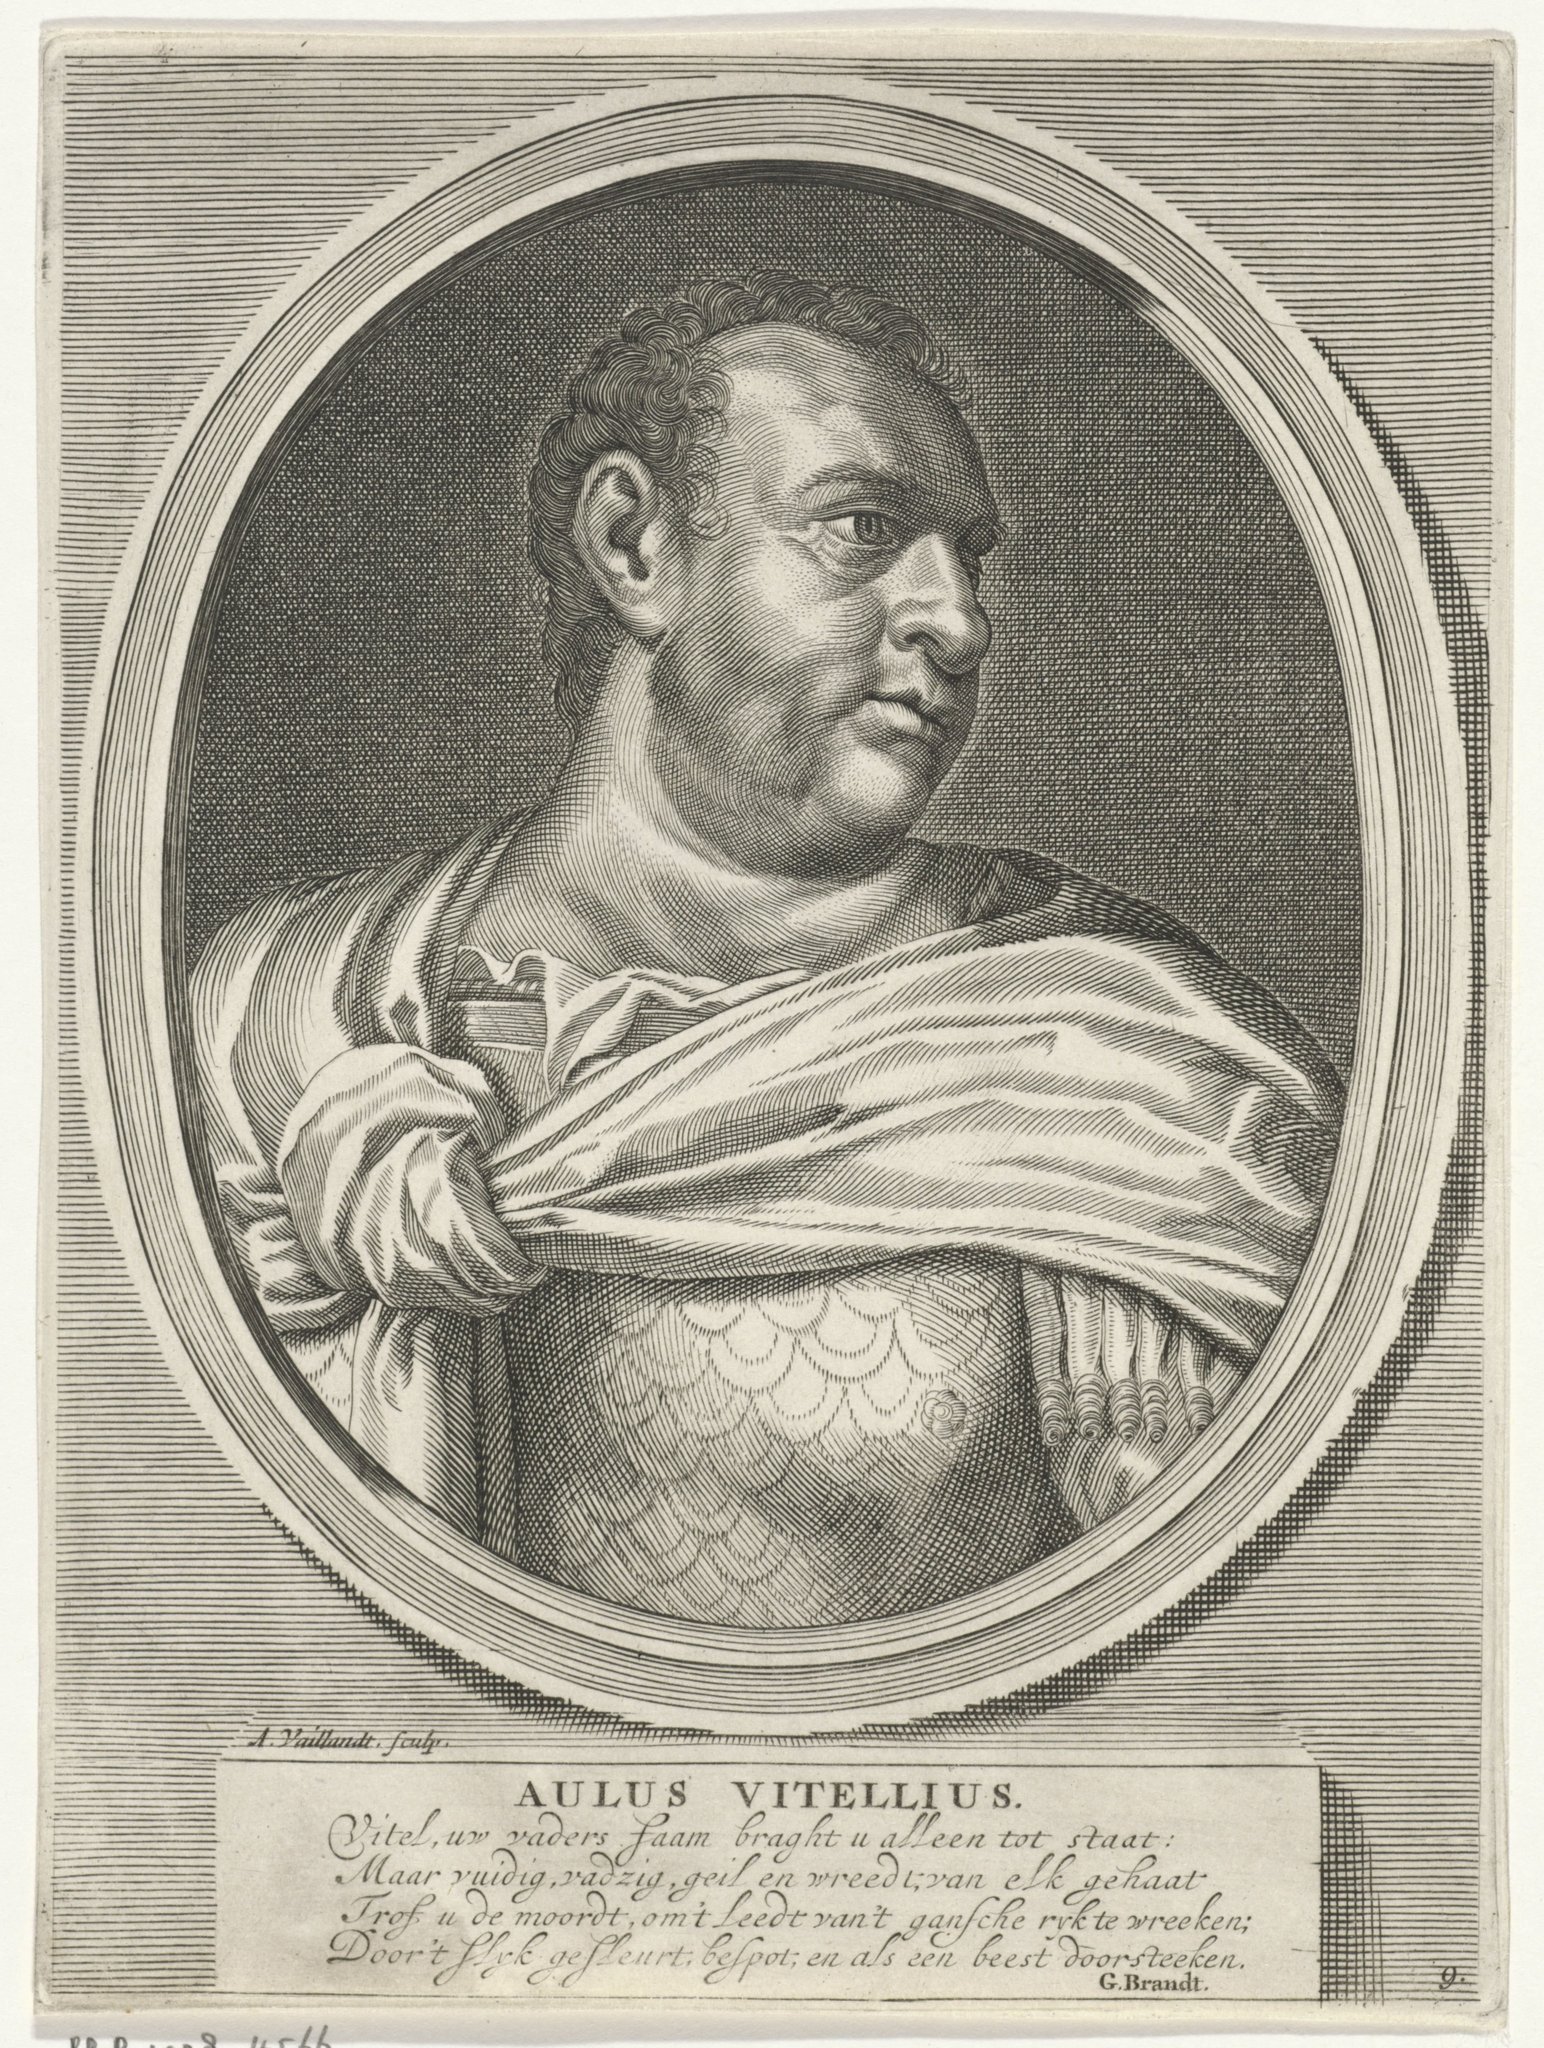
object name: print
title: Portret van Vitellius, Romeins keizer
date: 1665-1693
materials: paper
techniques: engraving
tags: rome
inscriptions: collector's mark: Lugt 2228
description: Portret van Vitellius, Romeins keizer. Prent uit een serie van veertien portretten van Romeinse keizers, Germanicus en Seneca.